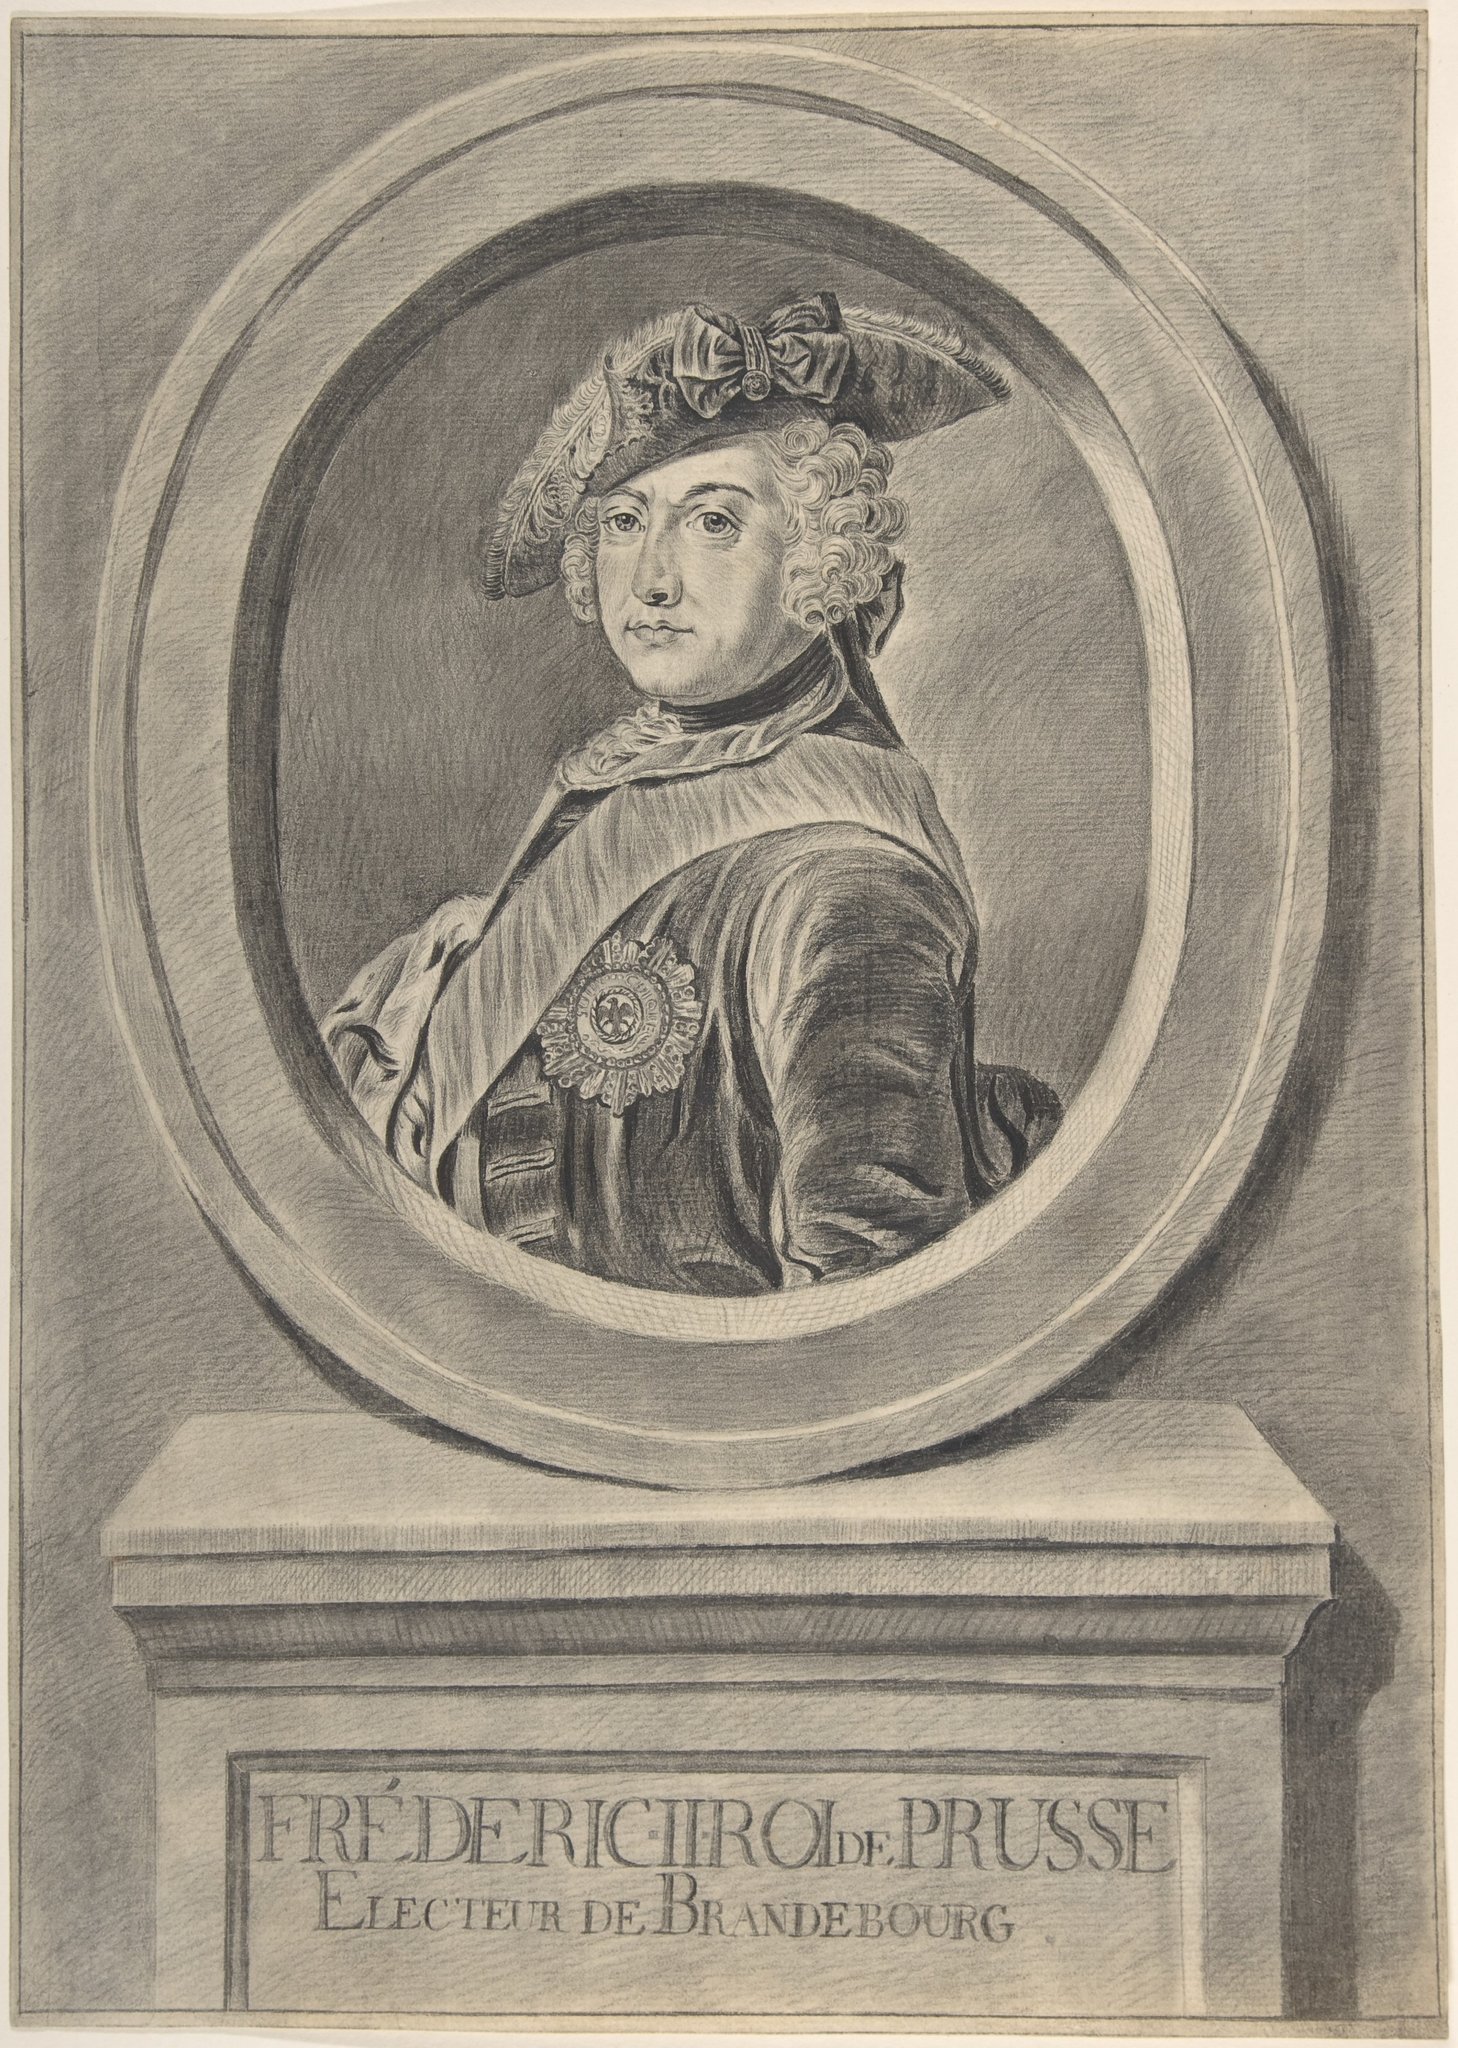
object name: drawing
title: Portrait of Frederick II of Prussia, after Antoine Pesne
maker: johann georg wille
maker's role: artist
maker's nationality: german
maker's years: 1715-1808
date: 1730-1808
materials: graphite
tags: men,portraits